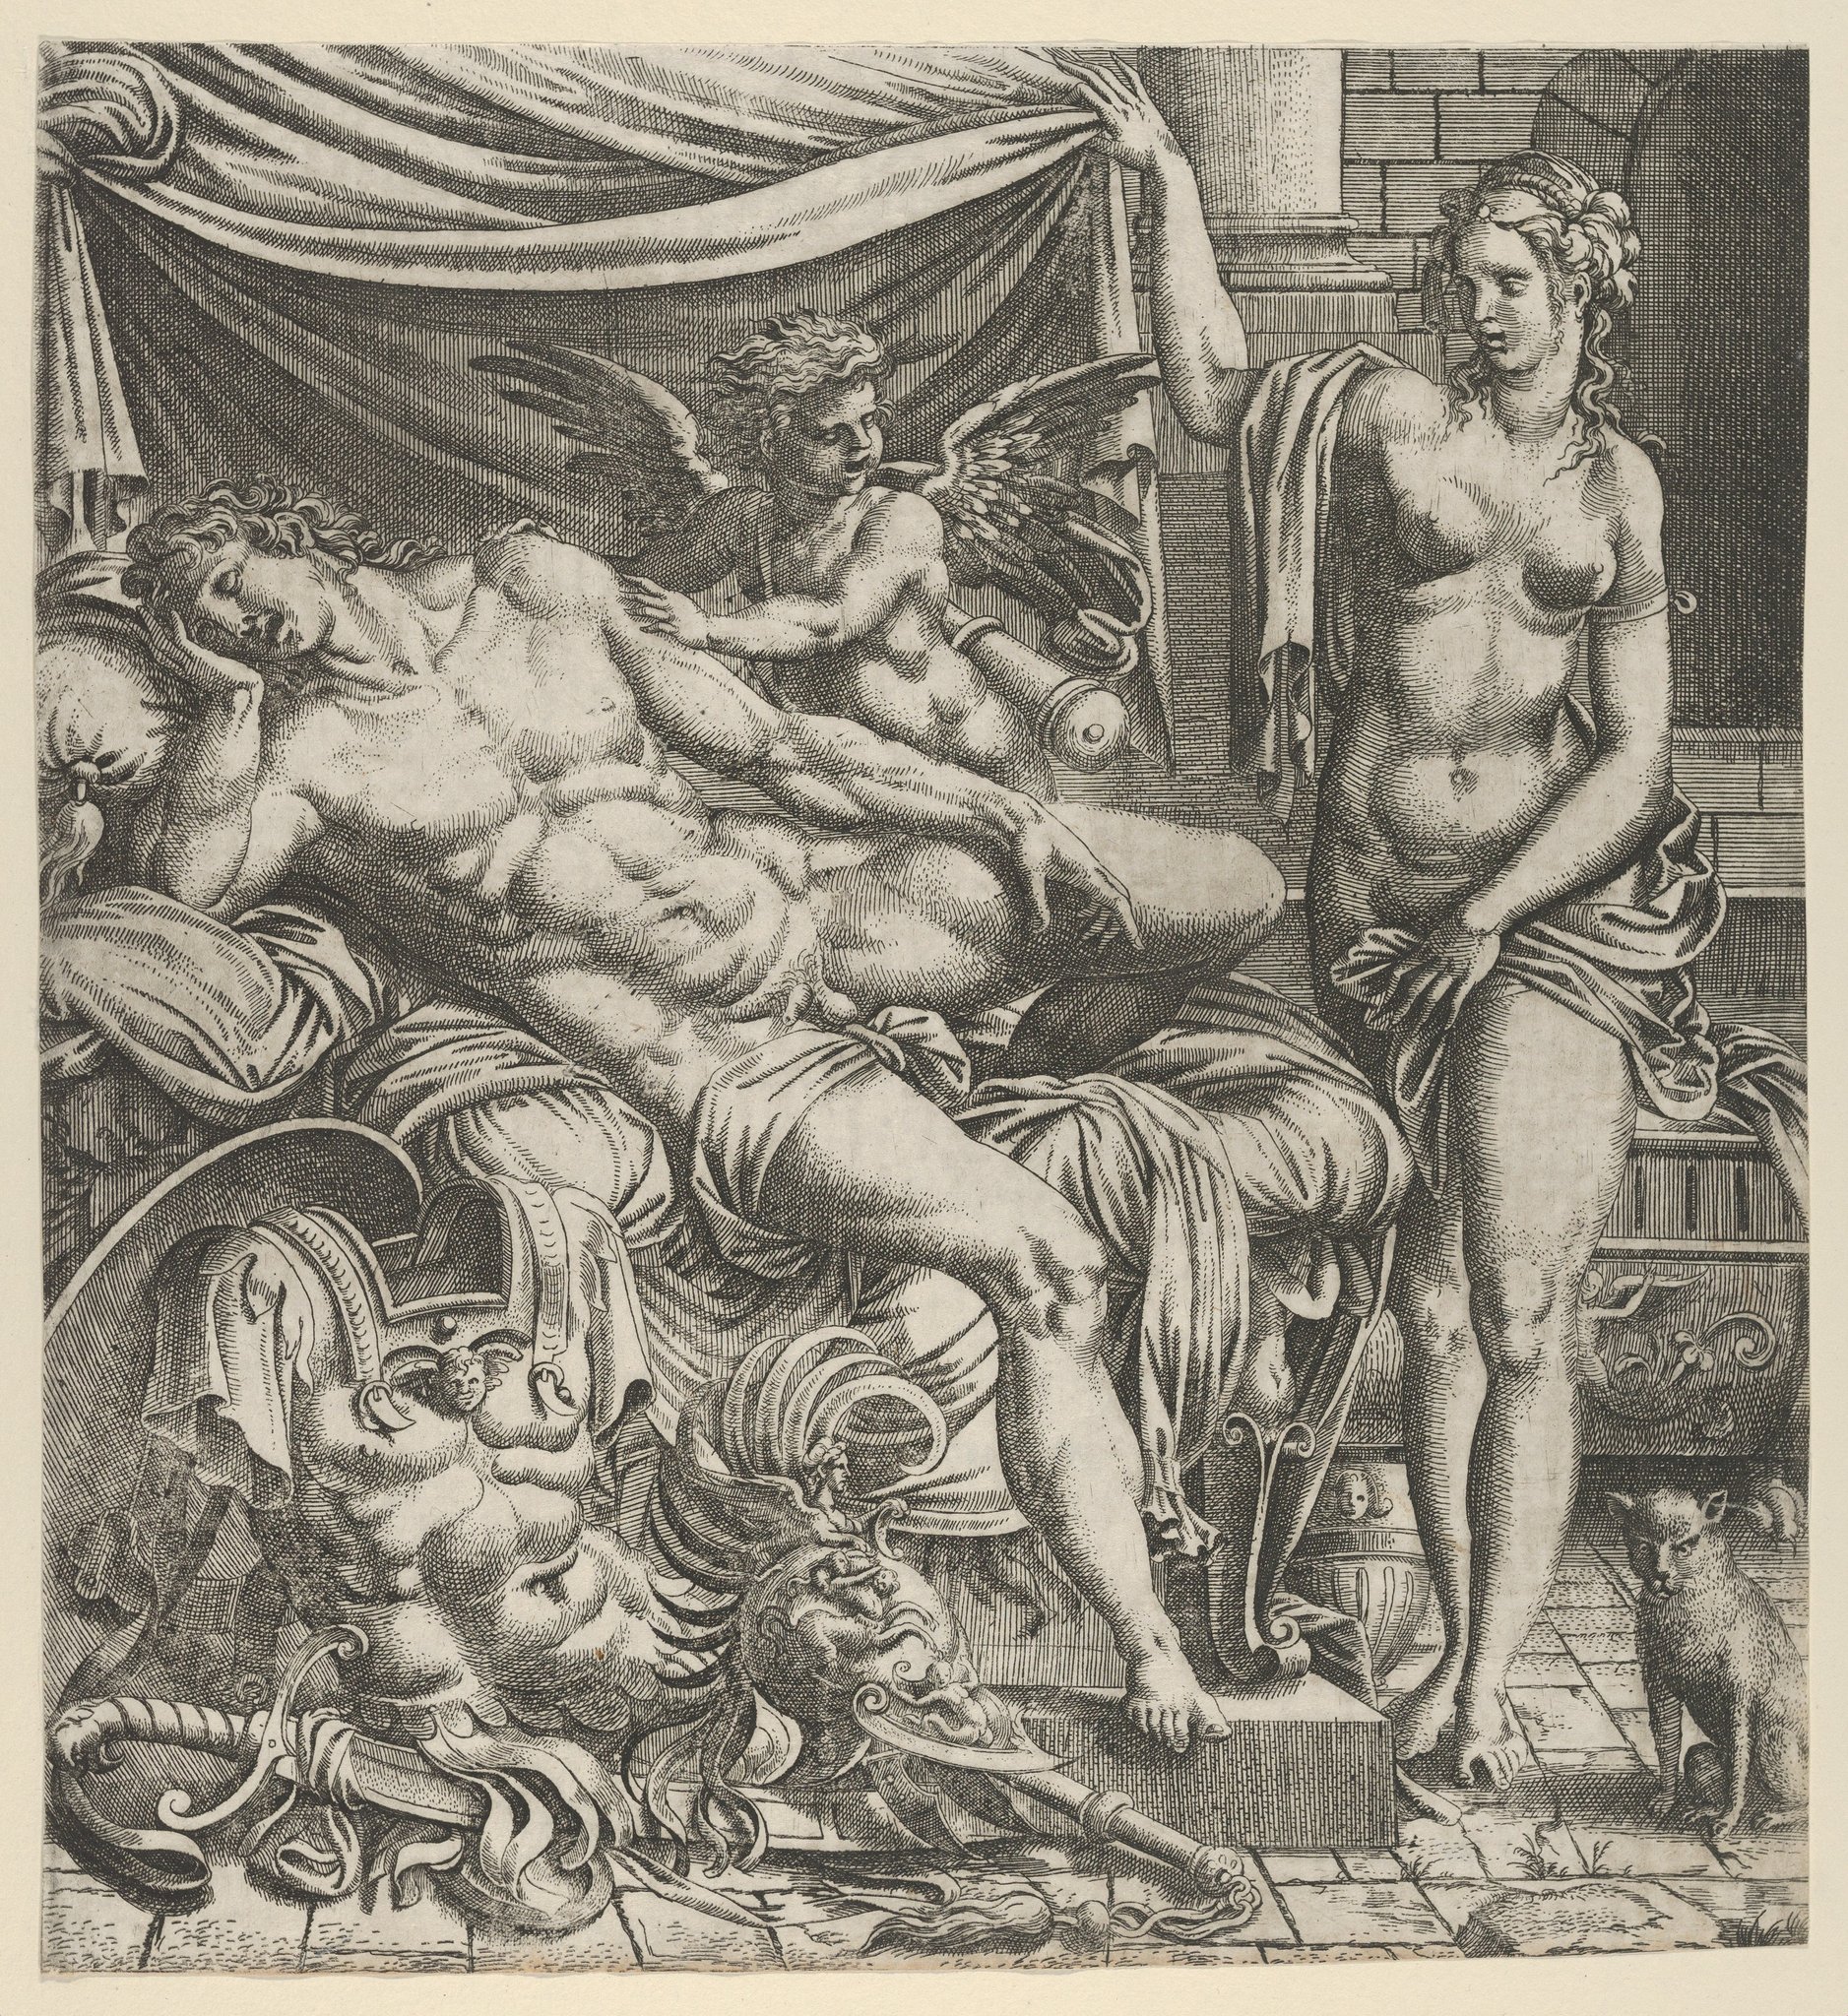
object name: print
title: Venus Finding Mars Asleep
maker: léon davent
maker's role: artist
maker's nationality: french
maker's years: 1540-1556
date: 1545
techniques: etching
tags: animals,sleeping,mars,venus,angels